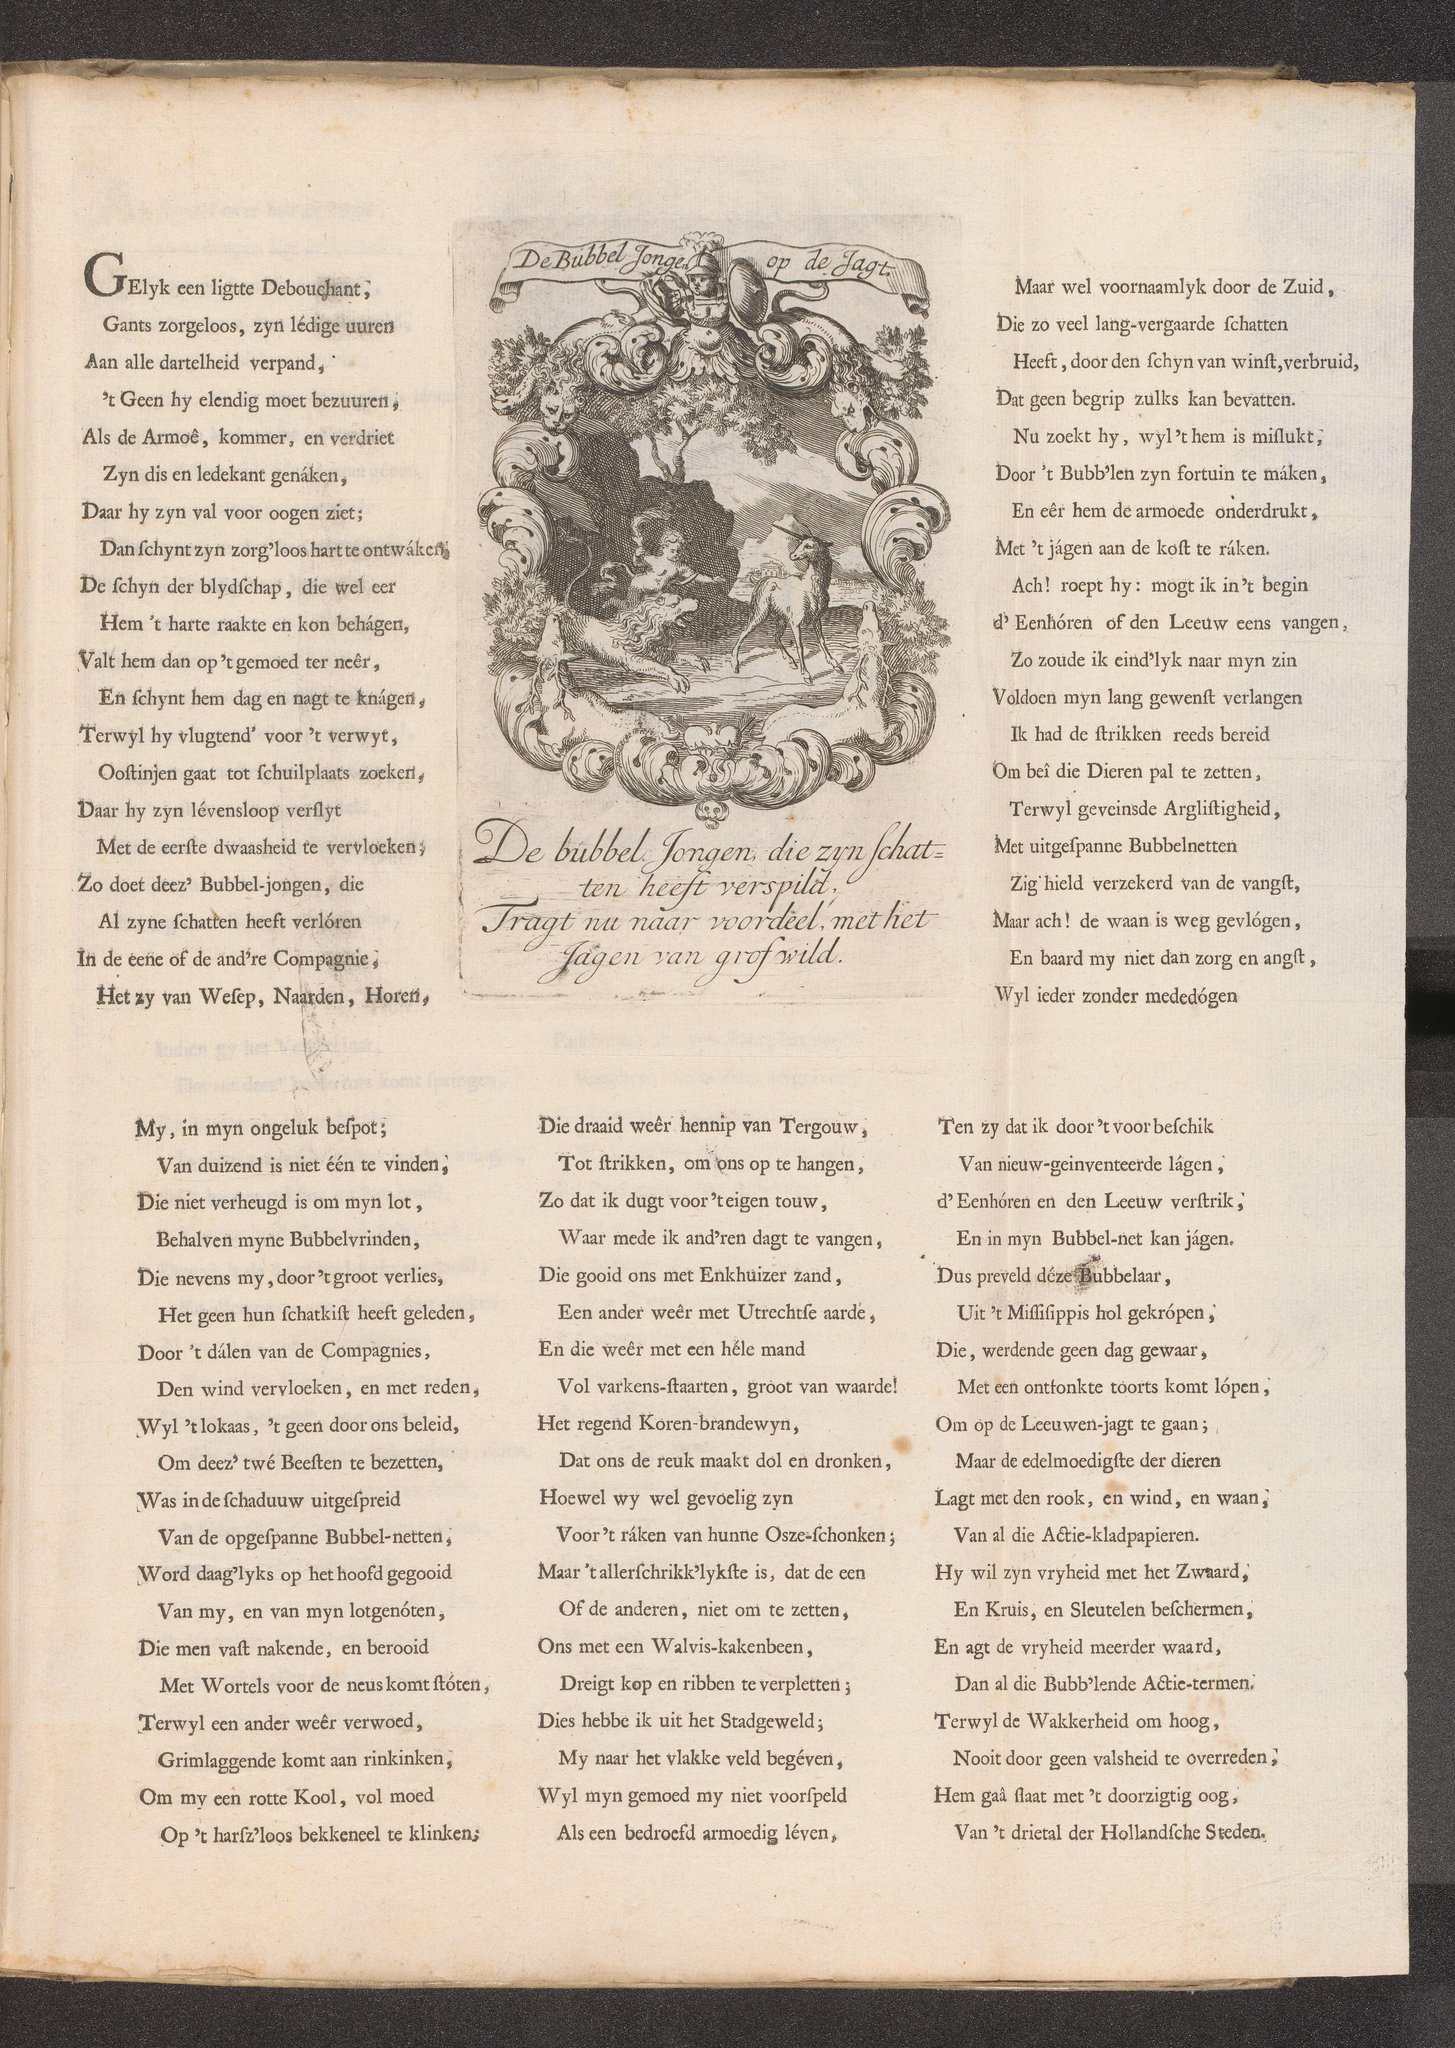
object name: print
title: Het Groote Tafereel der Dwaasheid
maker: pieter van den berge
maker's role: draughtsman, print maker, printer, publisher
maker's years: 1659-1737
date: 1697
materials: paper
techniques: engraving, etching, letterpress printing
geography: northern netherlands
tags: unicorn, hunting, chase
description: De Bubbeljongen op jacht. Een door de windwandel berooide naakte jongen jaagt met een fakkel op een leeuw en eenhoorn. In een decoratieve omlijsting met leeuwen en herten. In het onderschrift een vers van vier regels. Gedrukt op het blad om en onder de plaat staan vijf verzen. Prent in de gebonden eerste uitgave (304 B 10) van Het Groote Tafereel der Dwaasheid met spotprenten op de Windhandel of Actiehandel van 1720.